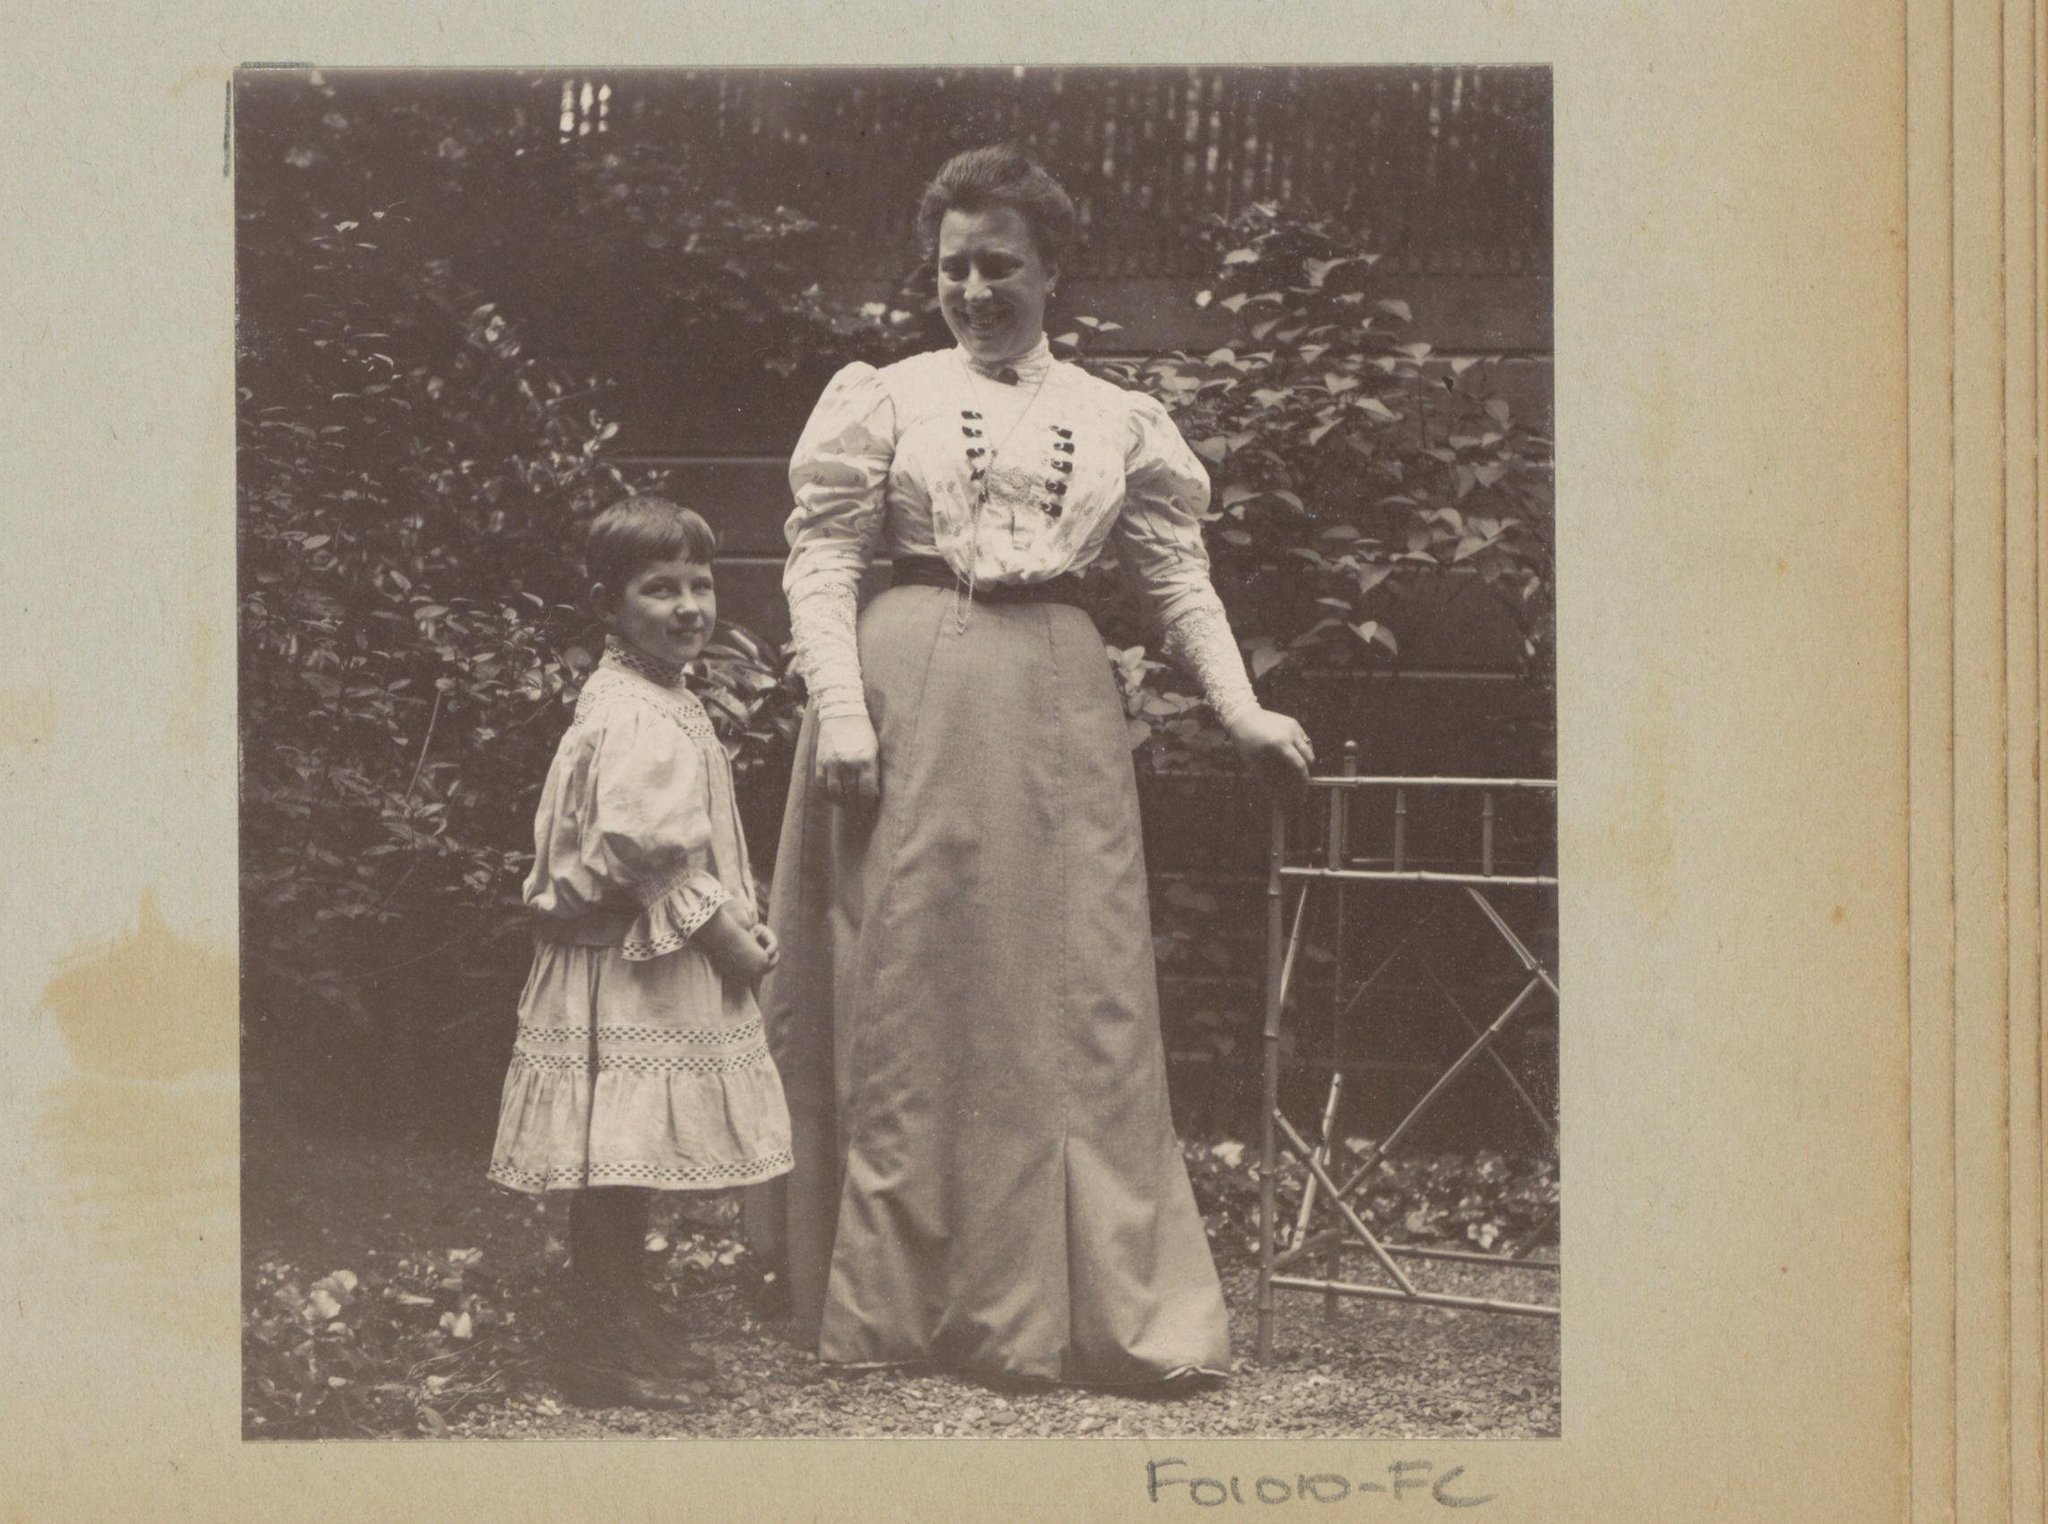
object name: photograph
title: Vrouw en een meisje, staand in een tuin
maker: Anonymous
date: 1900-1910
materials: photographic support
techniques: daylight paper print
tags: garden, mother and baby or young child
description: Onderdeel van Familiealbum met onder meer foto's van Wijnhandel Kraaij & Co. Bordeaux-Amsterdam.